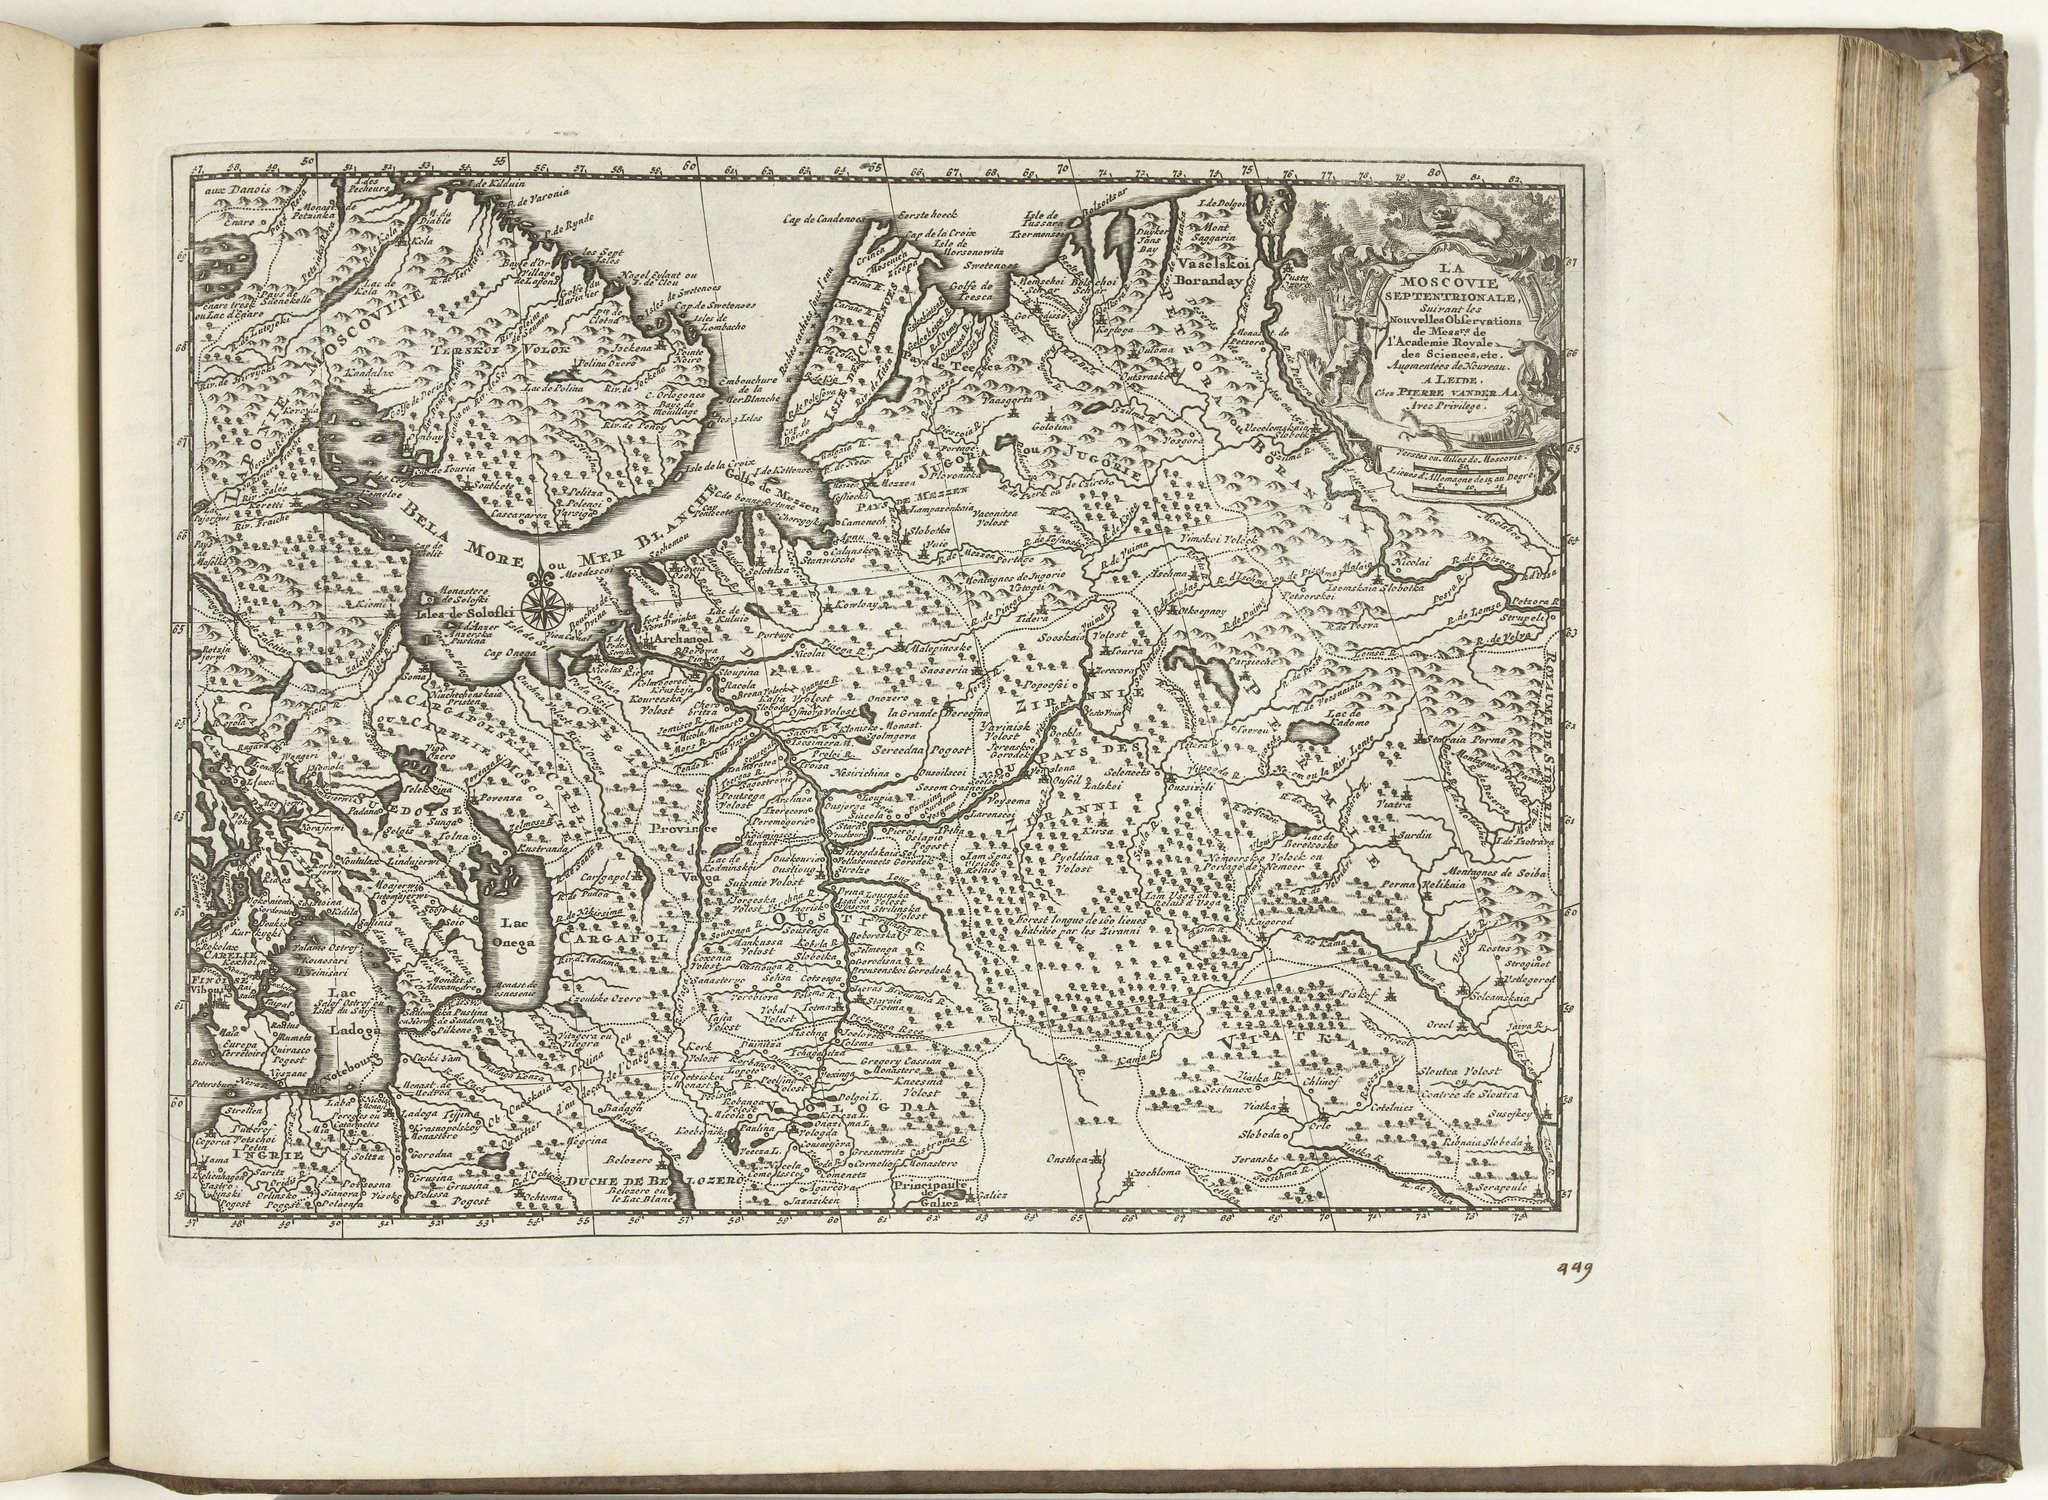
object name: print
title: Les Forces de l'Europe, Asie, Afrique et Amerique (...) Comme aussi les Cartes des Côtes de France et d'Espagne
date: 1726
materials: paper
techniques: engraving, etching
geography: leiden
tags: maps of separate countries or regions, russia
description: Kaart van Moskovië, het noordelijke deel van Rusland tot aan de Witte Zee. Plaat nr. 449 in deel XVIII van het prentwerk: Les Forces de l'Europe, Asie, Afrique et Amerique ... Comme aussi les Cartes des Côtes de France et d'Espagne uit 1726, dit tweede deel met 271 met de hand genummerde platen van vermaarde sterke steden en vestingen in het kader van de Spaanse Successieoorlog 1701-1713. Voor het merendeel zijn deze platen gekopieerd naar de anonieme Franse platen van vermaarde sterke steden en vestingen: in Les forces de l'Europe en in: Le theatre de la guerre, dans les Pays-Bas, beide oorspronkelijk uitgegeven door Nicolas de Fer te Parijs (1693-1697) in het kader van de Negenjarige Oorlog. Titel en opschriften in het Frans.